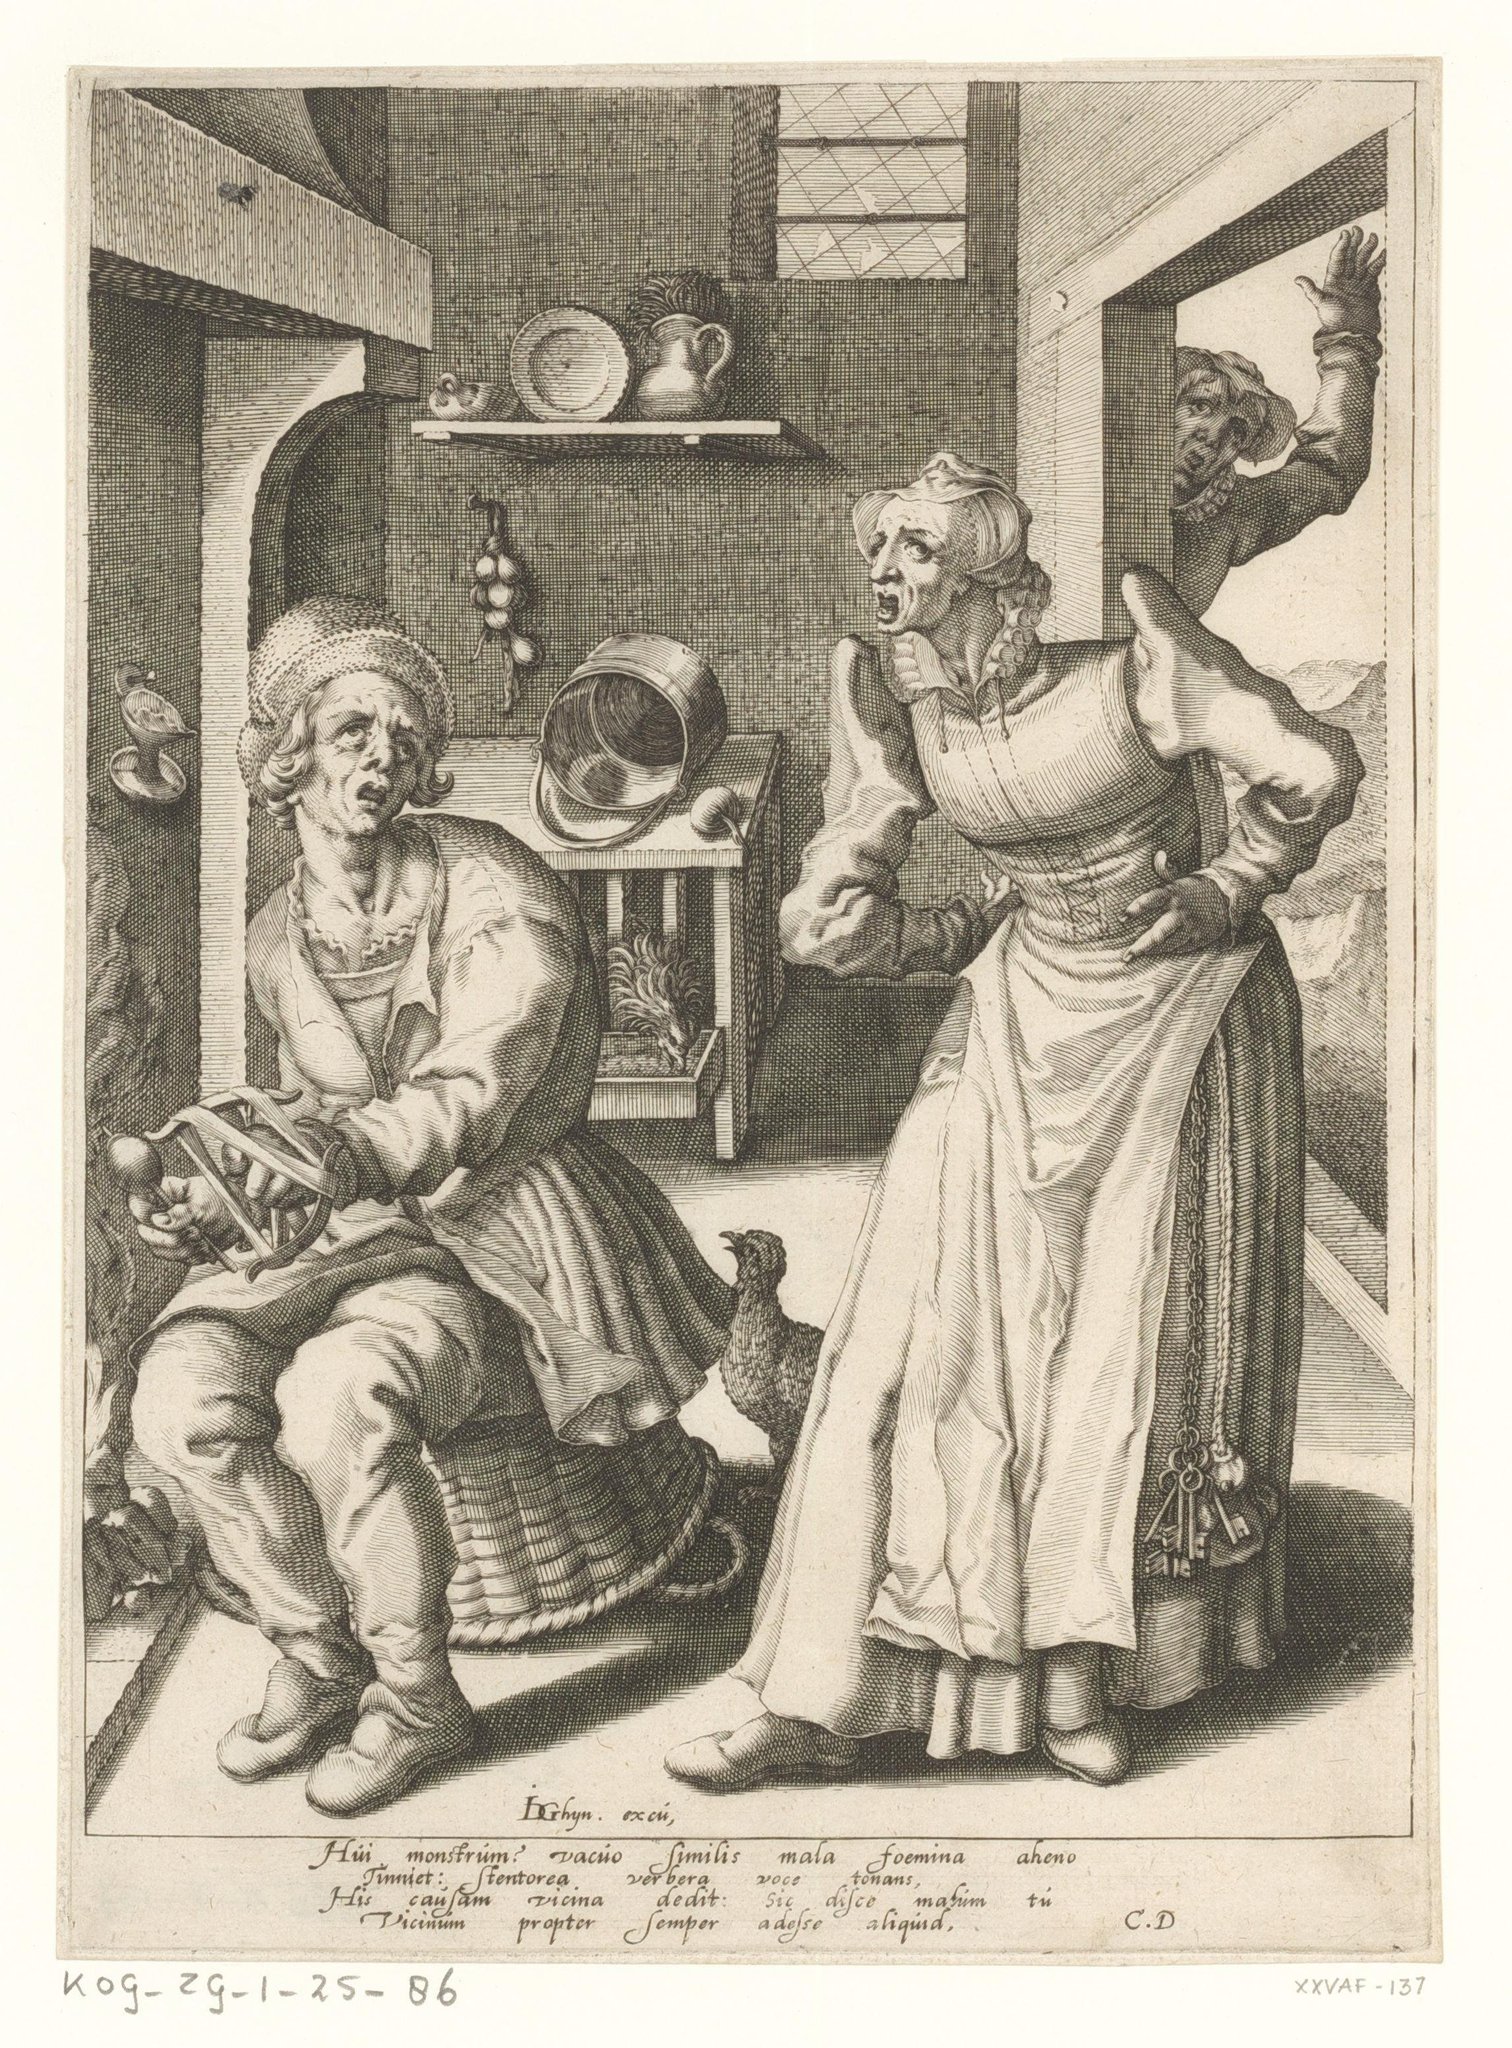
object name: print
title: Kijvende vrouw en een spinnende man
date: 1595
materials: paper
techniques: engraving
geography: netherlands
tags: man and wife quarrelling, 'marriage à la mode', fighting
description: Een vrouw staat in een keuken met de handen in de zij te schreeuwen naar een man die bij een haardvuur met spinrokken in de weer is. Op de achtergrond bij de deuropening het bovenlijf van een tweede vrouw, die de arm opsteekt. Onder de voorstelling vier regels tekst in Latijn. Onderwerpsrubrieken binnen de Atlas Zeden en Gewoonten: Zeden en Gewoonten in Engeren Zin, De Woning, Binnenhuizen, Keukens.